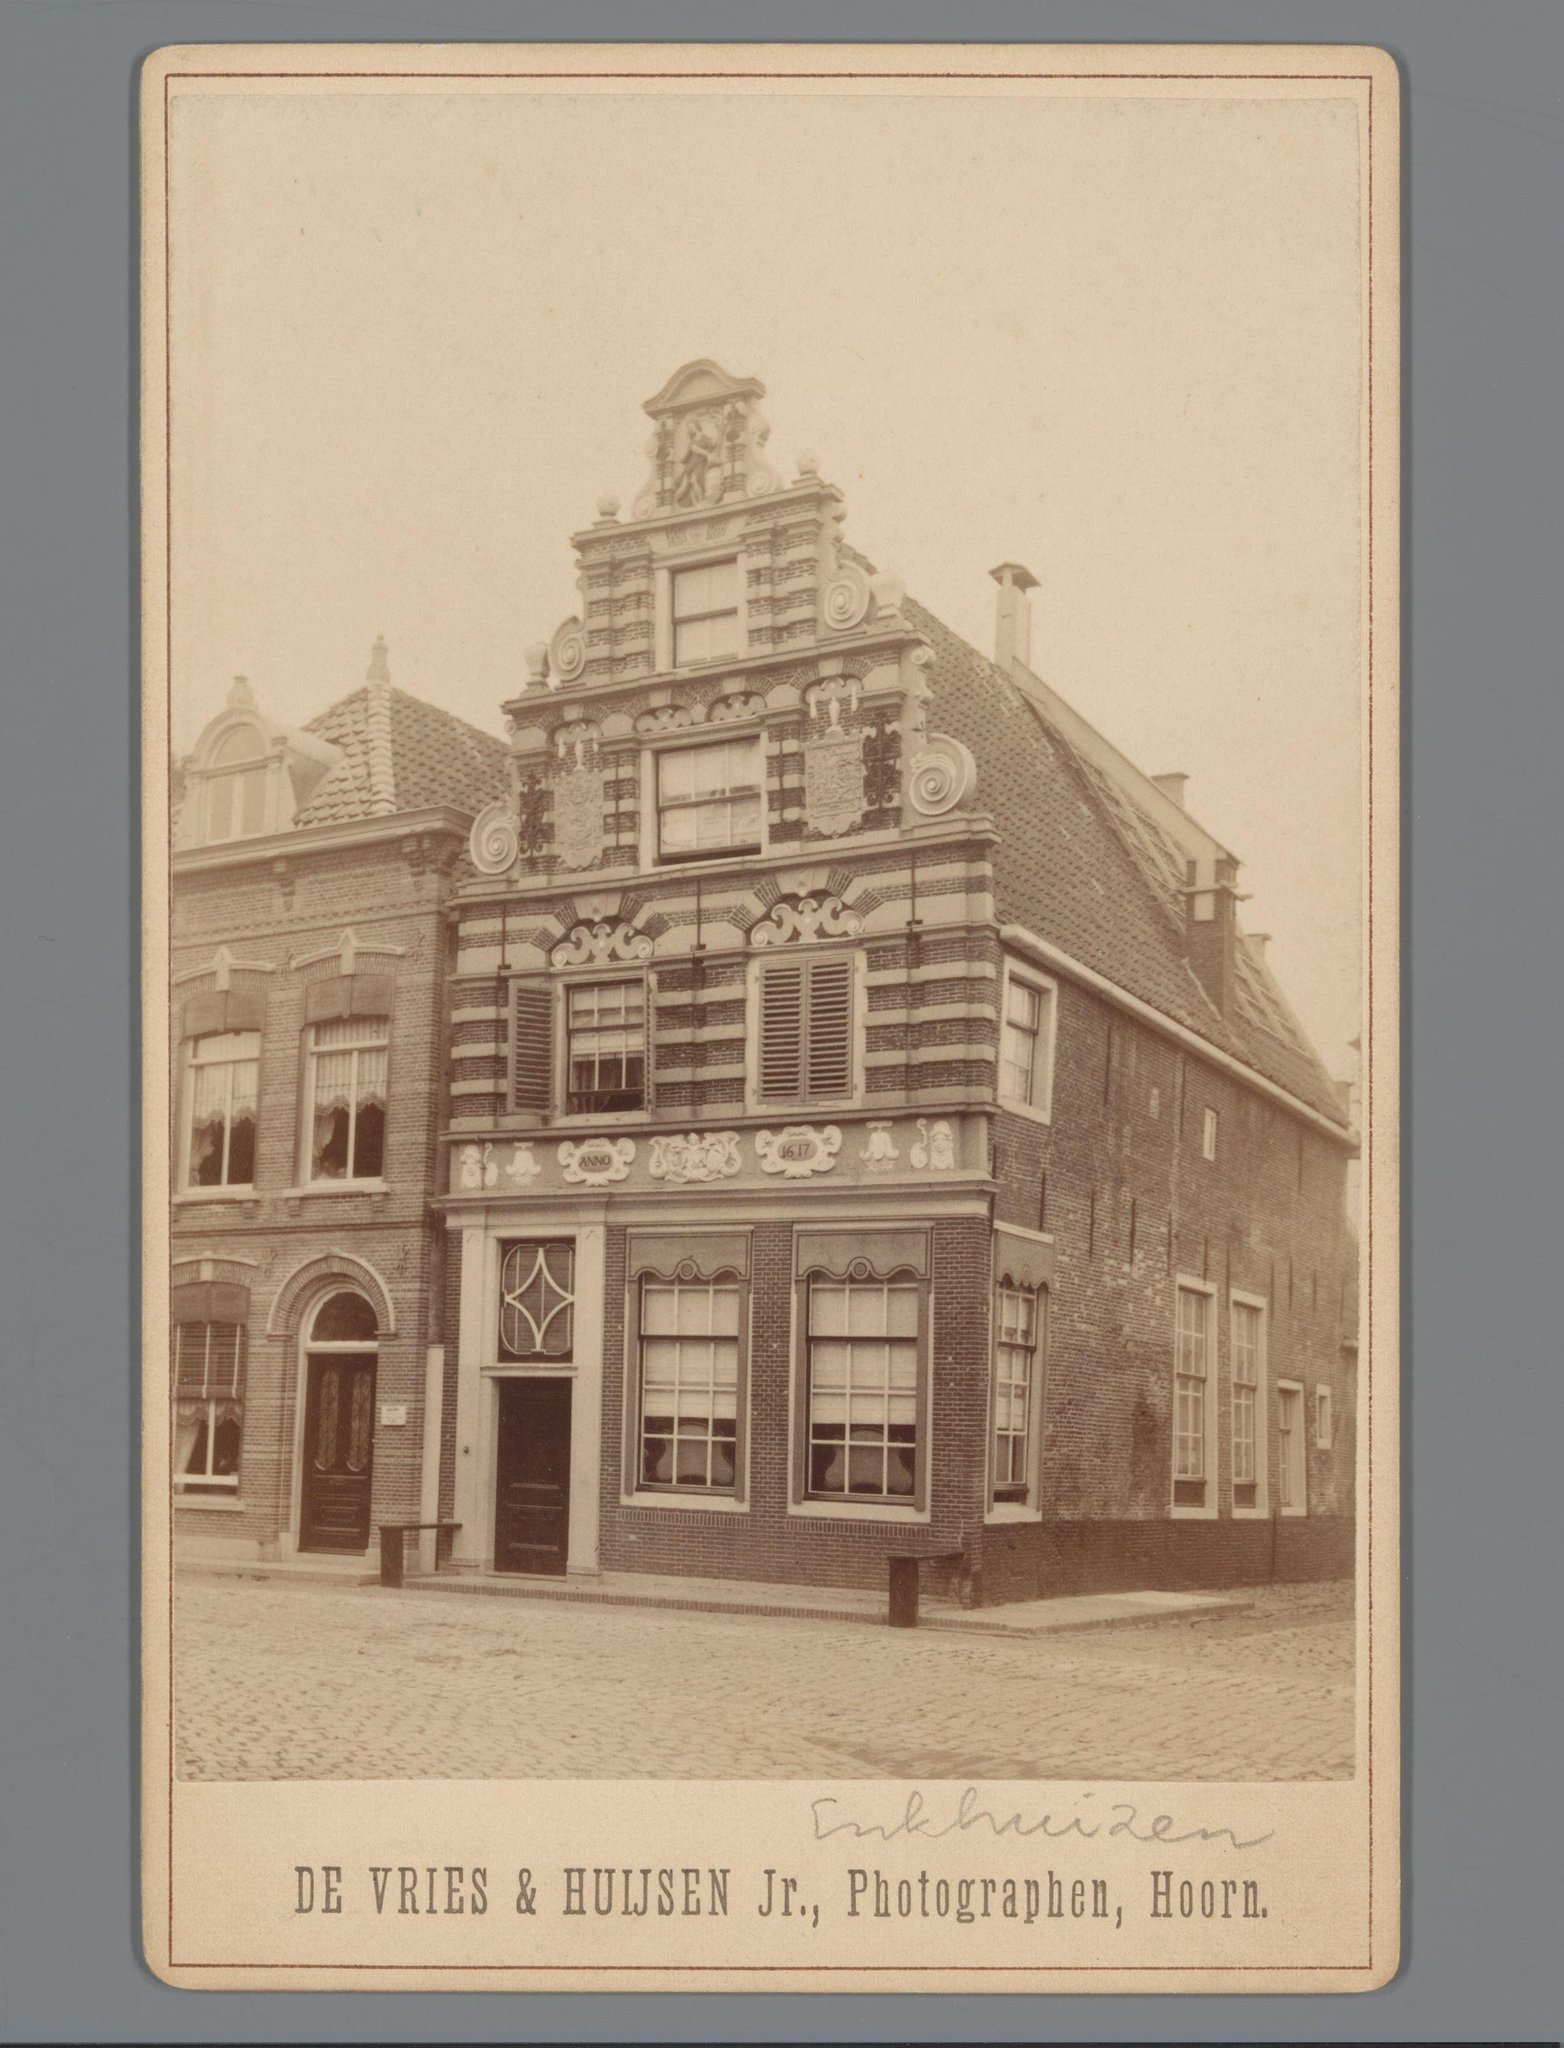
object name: photograph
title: Façade van een huis te Enkhuizen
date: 1870-1900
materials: cardboard, photographic support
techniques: albumen print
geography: enkhuizen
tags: urban housing, façade (of house or building), enkhuizen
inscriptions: inscription: ‘De Vries & Huijsen Jr., Photographen, Hoorn.’, annotation: ‘Enkhuizen/ VI/3 f’, annotation: ‘Enkhuizen’